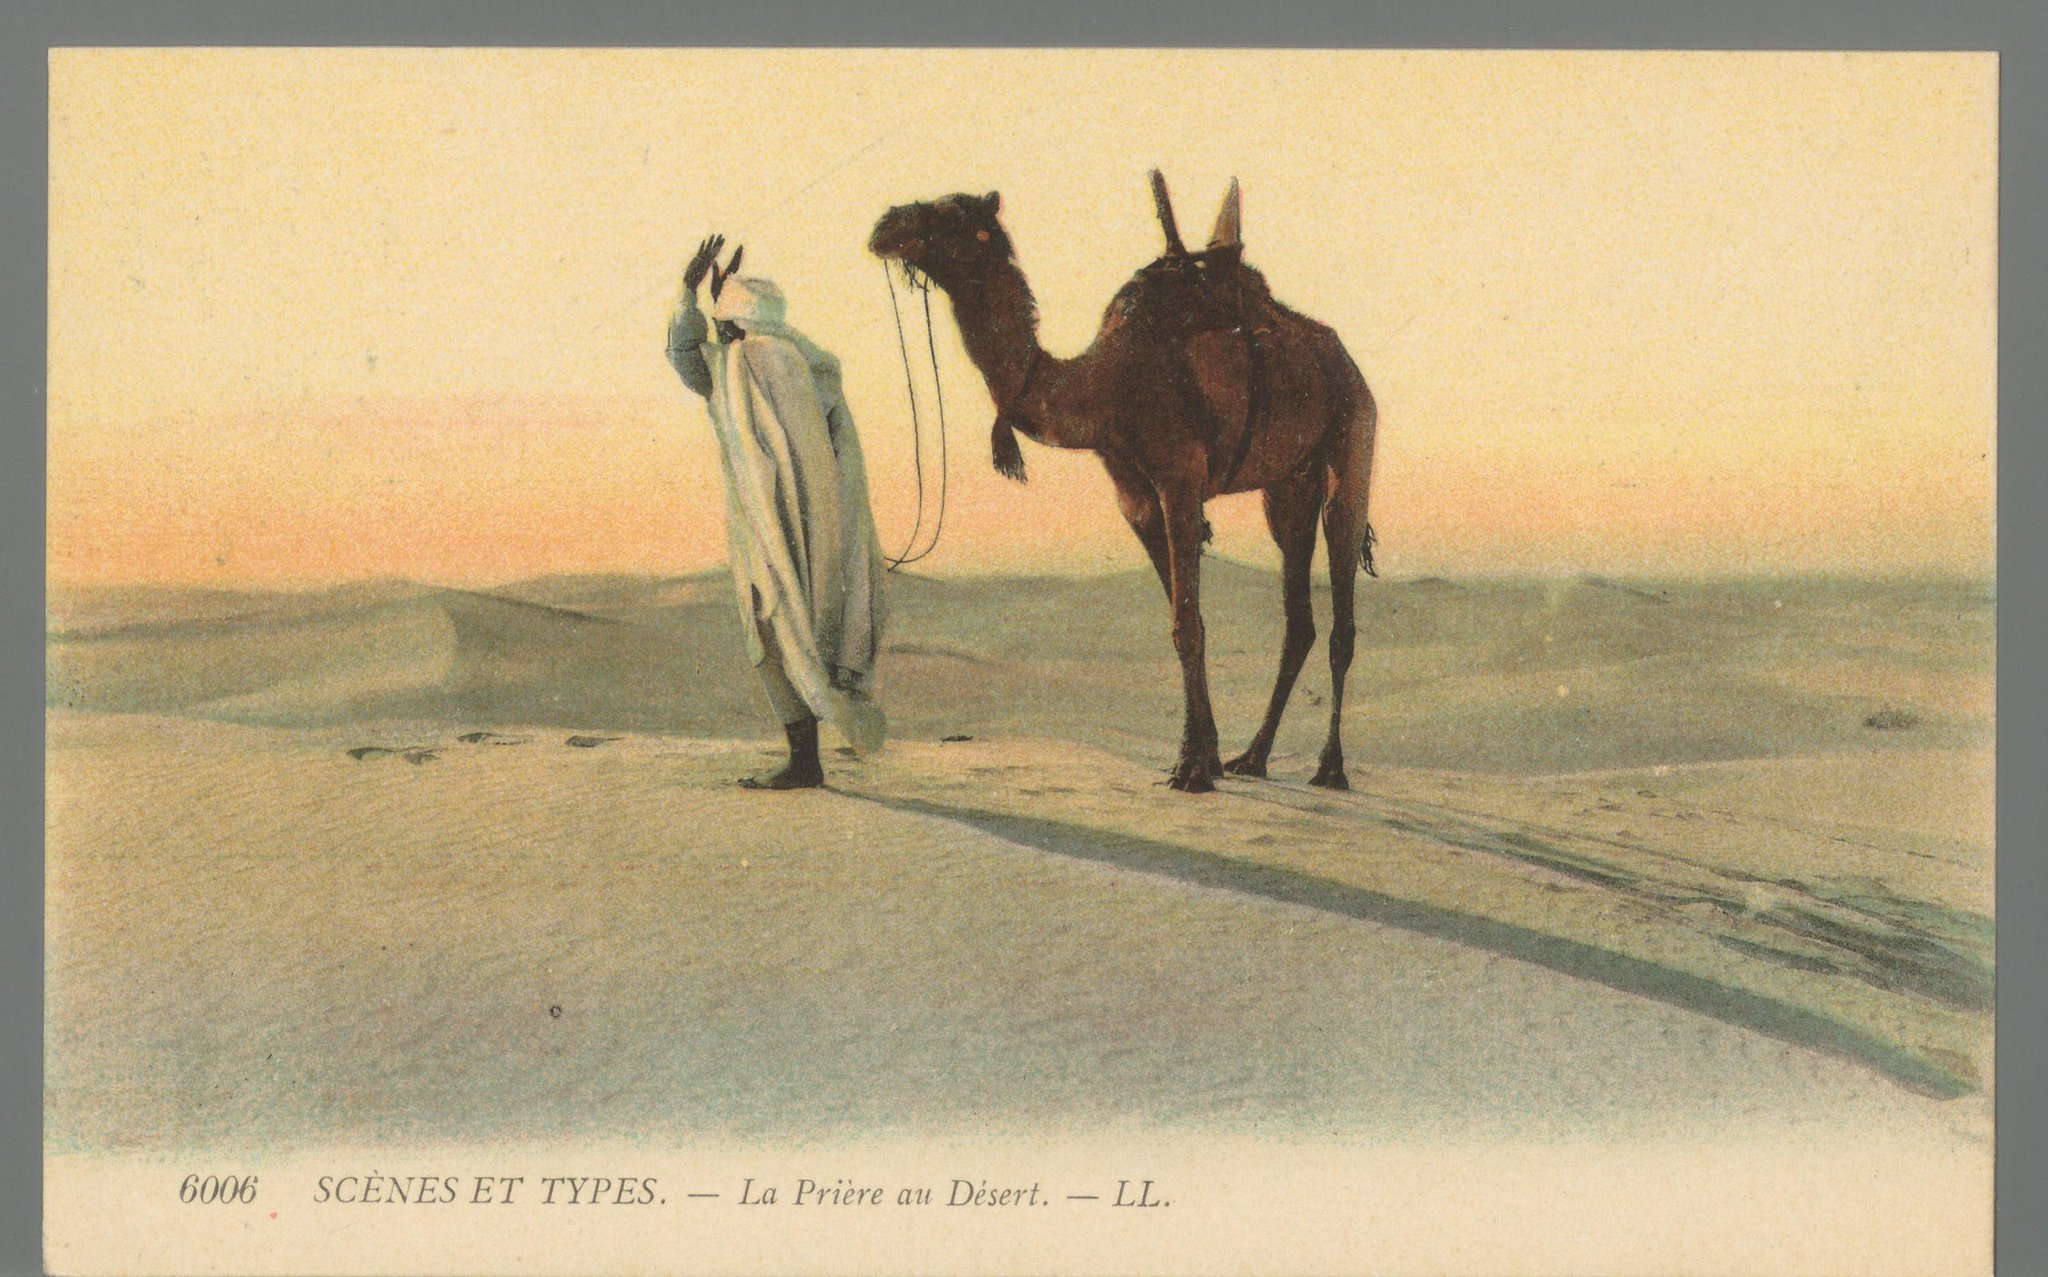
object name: photomechanical print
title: Scènes et types - La prière au désert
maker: Anonymous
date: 1907-1930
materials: cardboard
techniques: photograph, lithograph, writing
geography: paris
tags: hoofed animals: camel, desert, one person praying